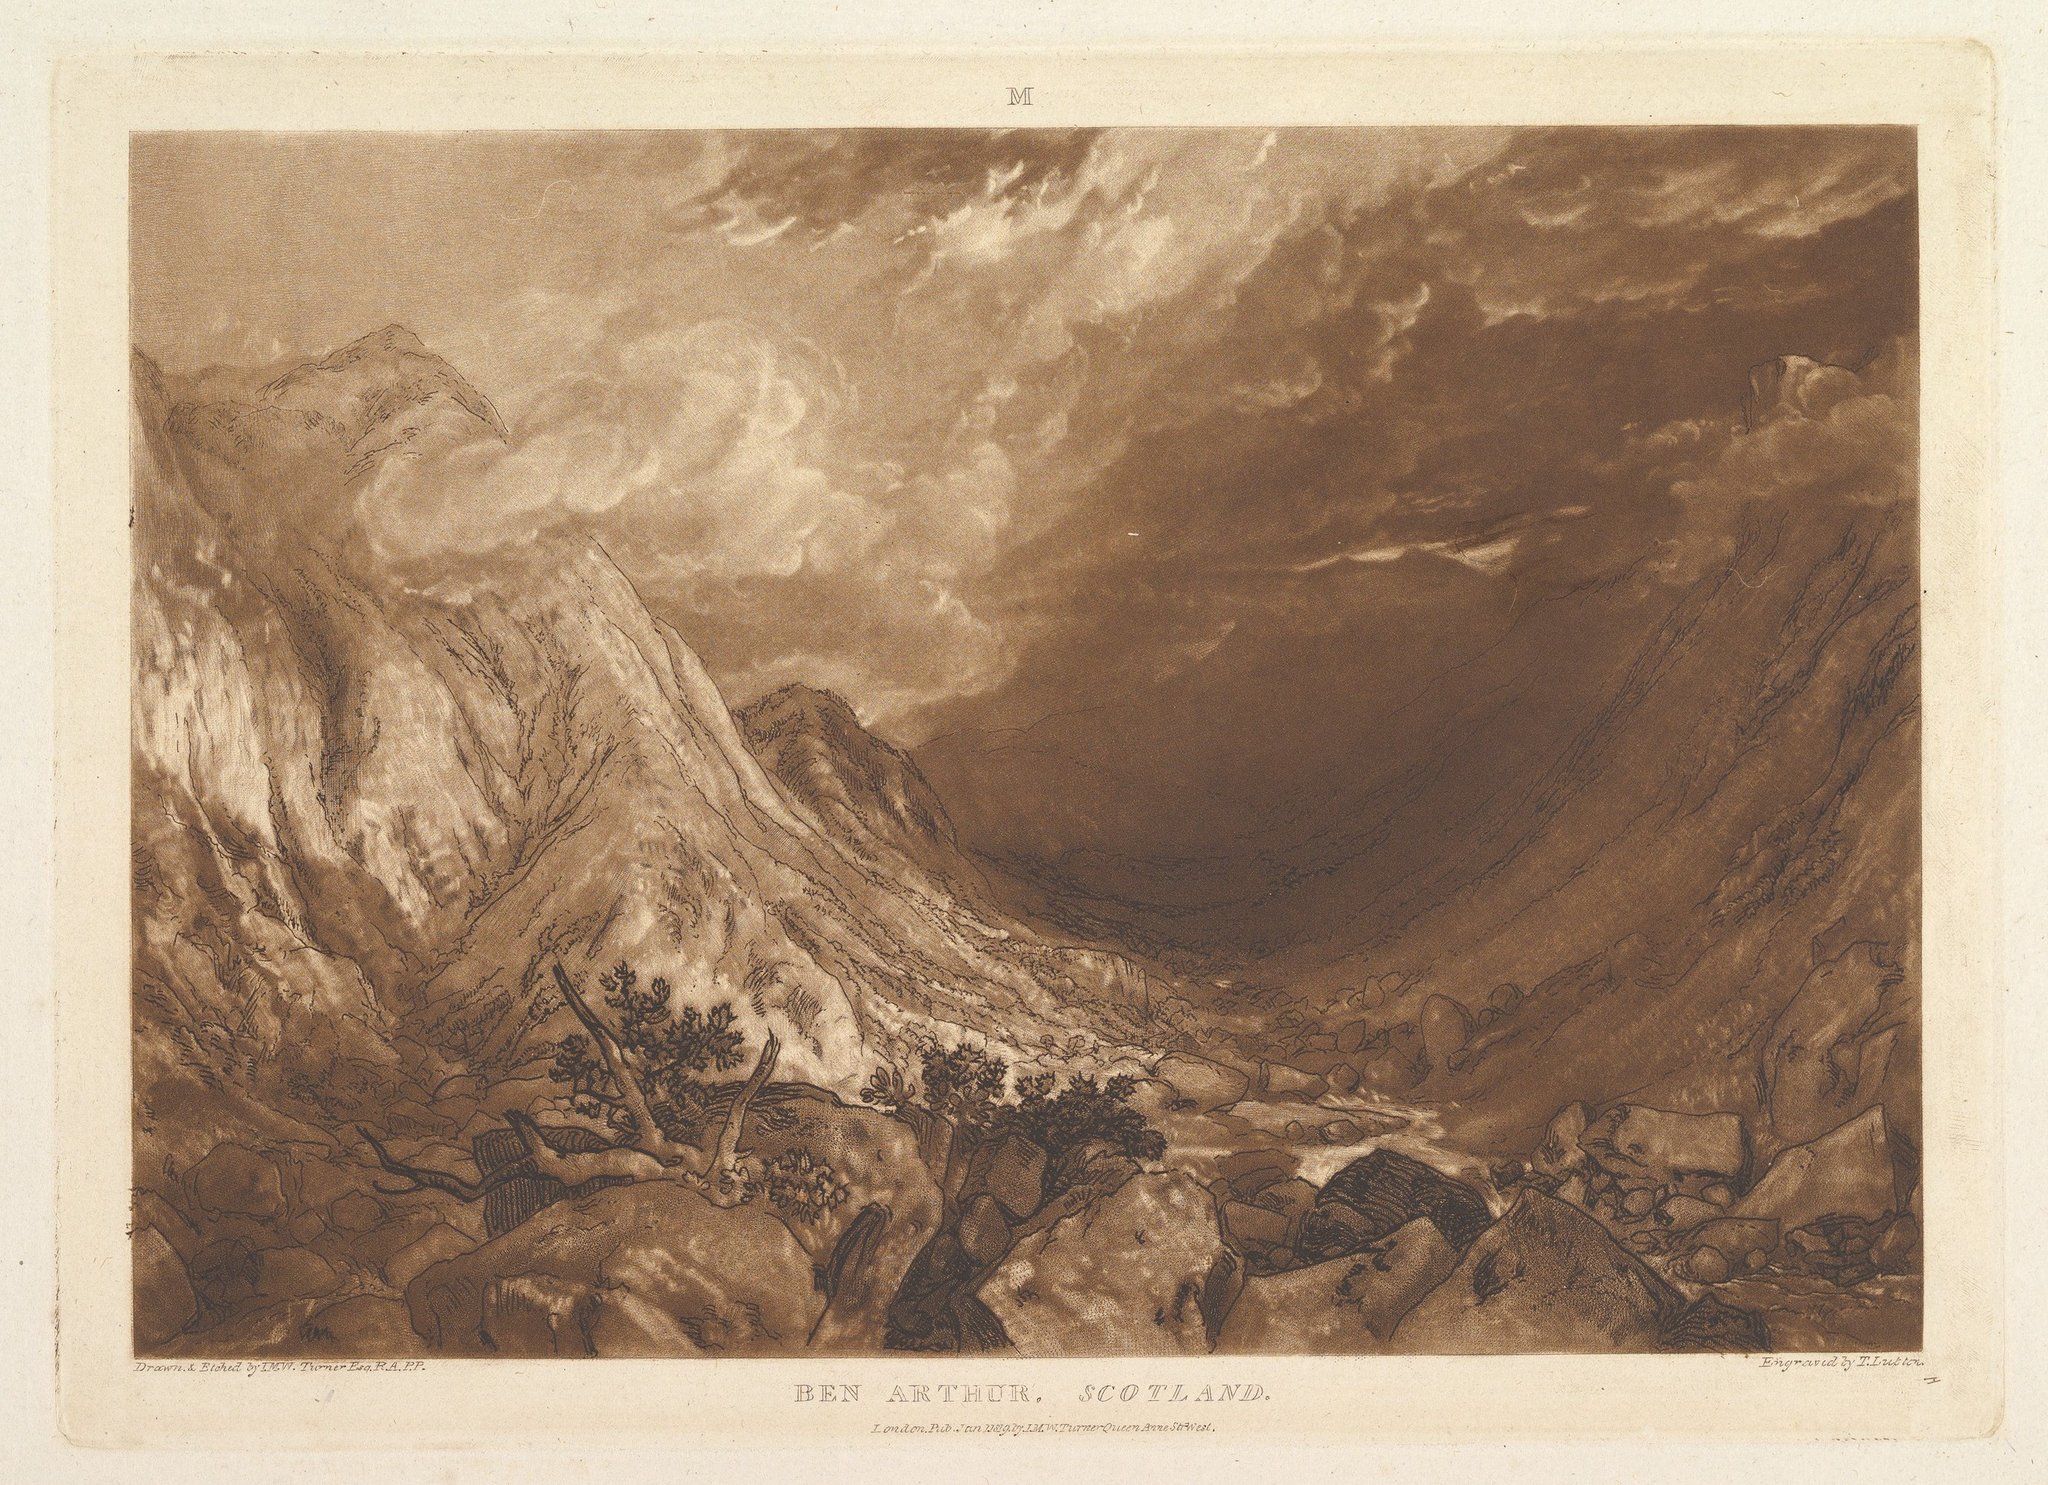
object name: print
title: Ben Arthur, Scotland (Liber Studiorum, part XIV, plate 69)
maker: joseph mallord william turner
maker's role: artist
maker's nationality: british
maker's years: 1775-1851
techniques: etching, mezzotint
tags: mountains,landscapes